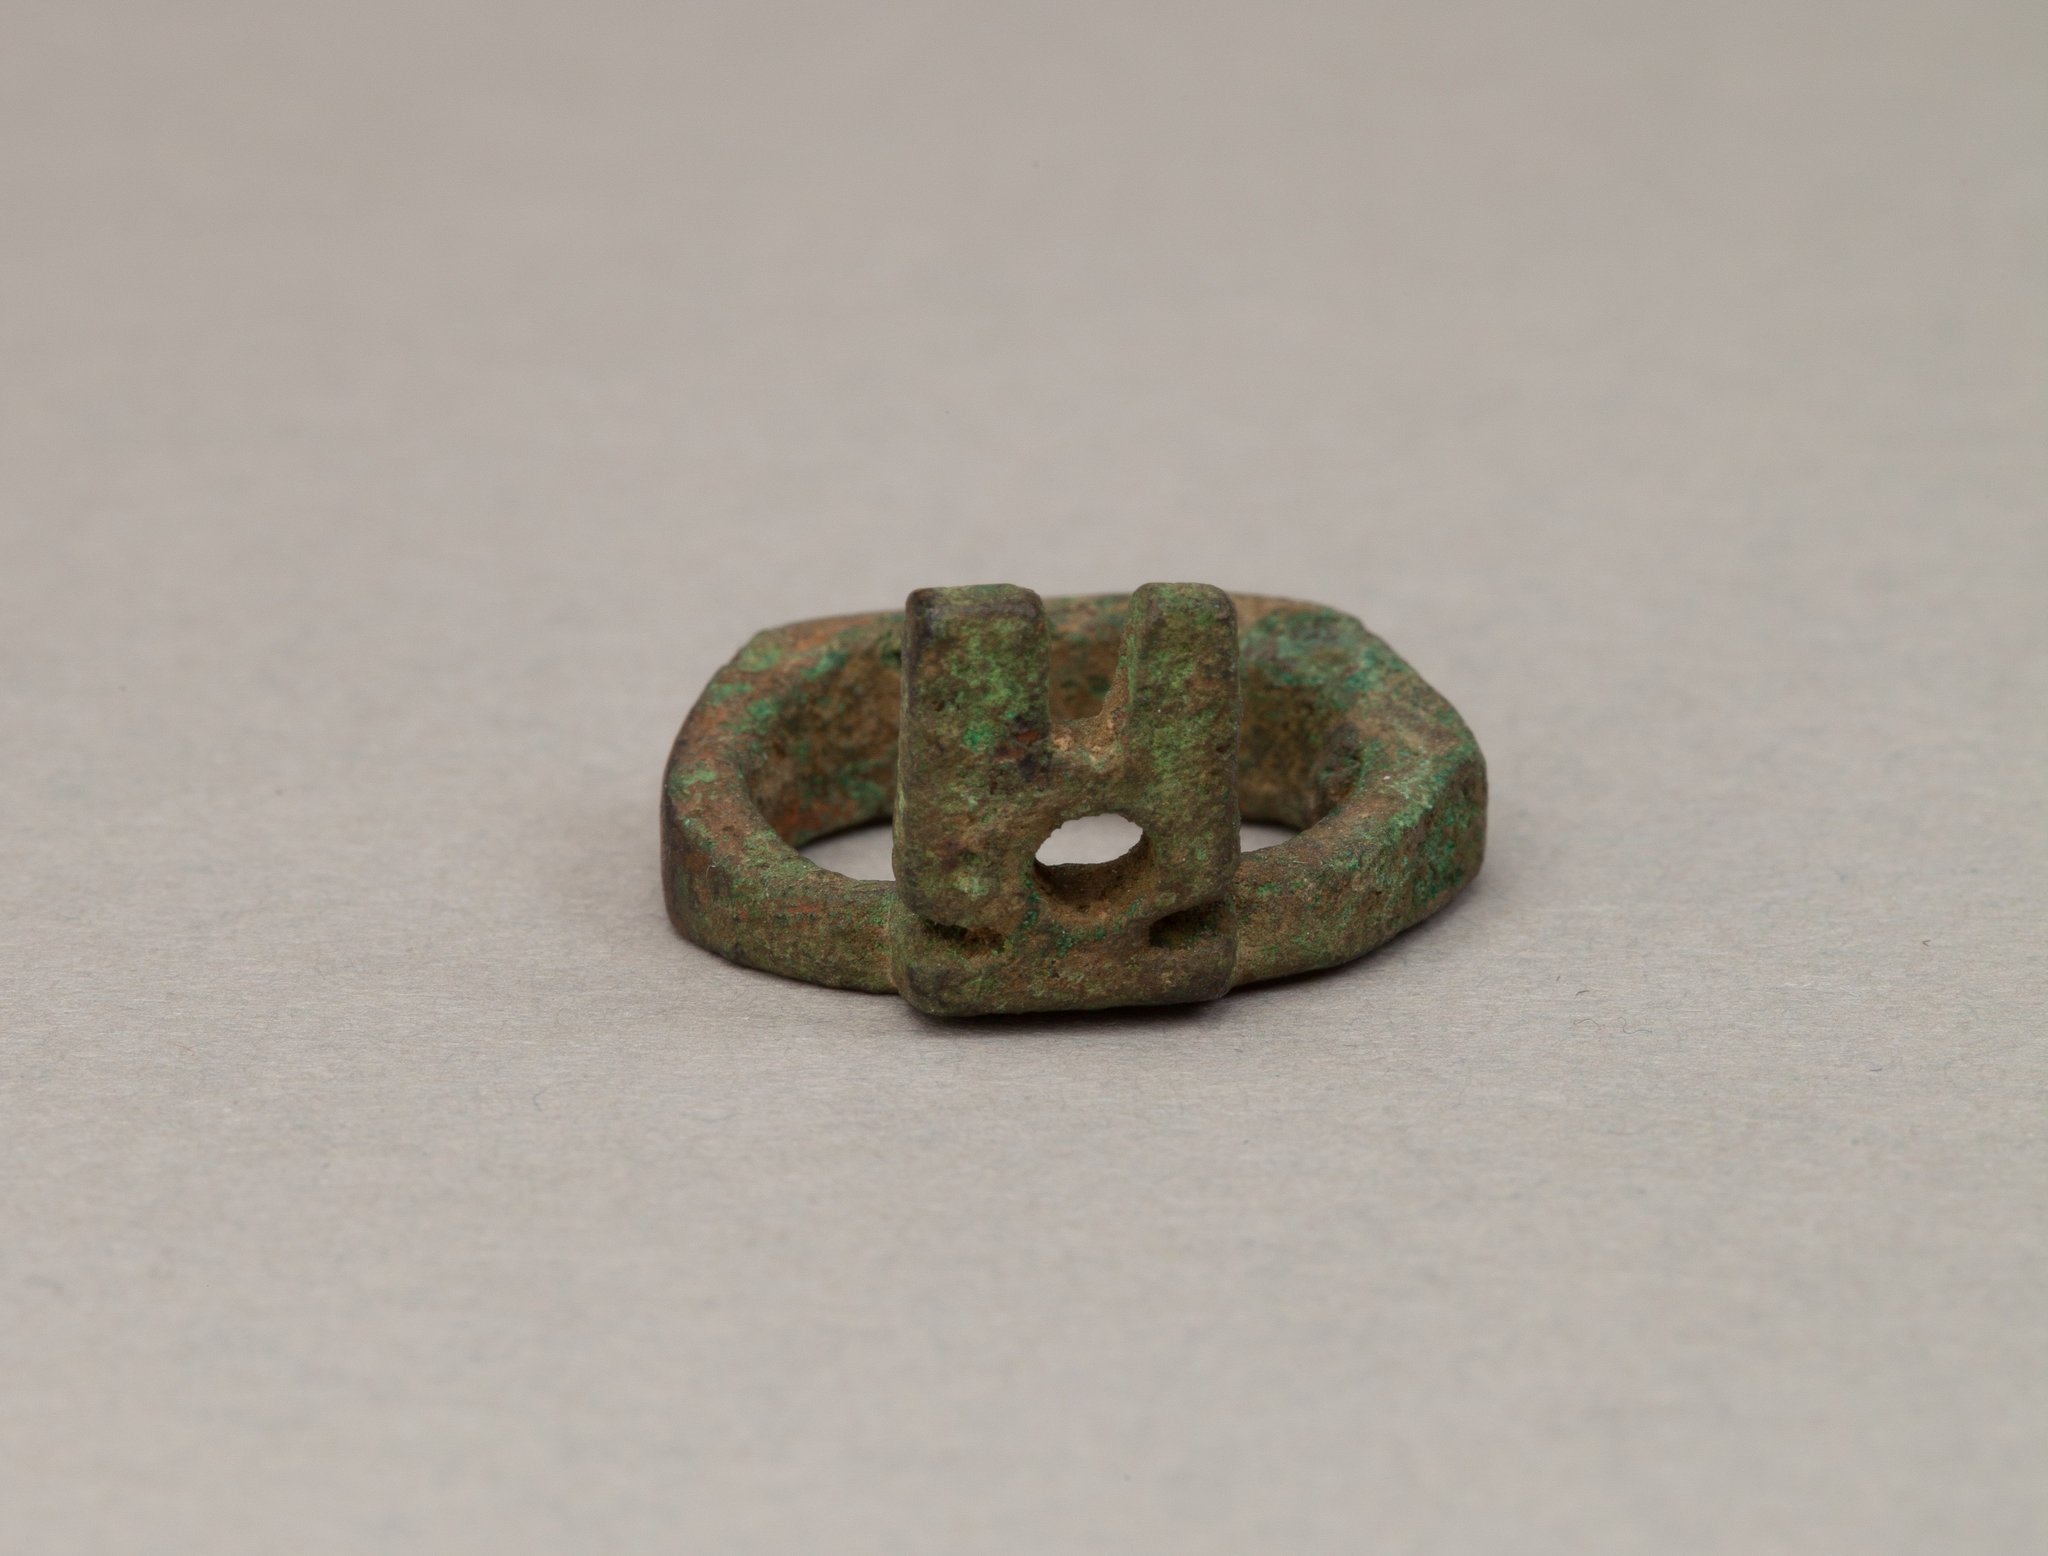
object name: key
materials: copper alloy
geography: egypt